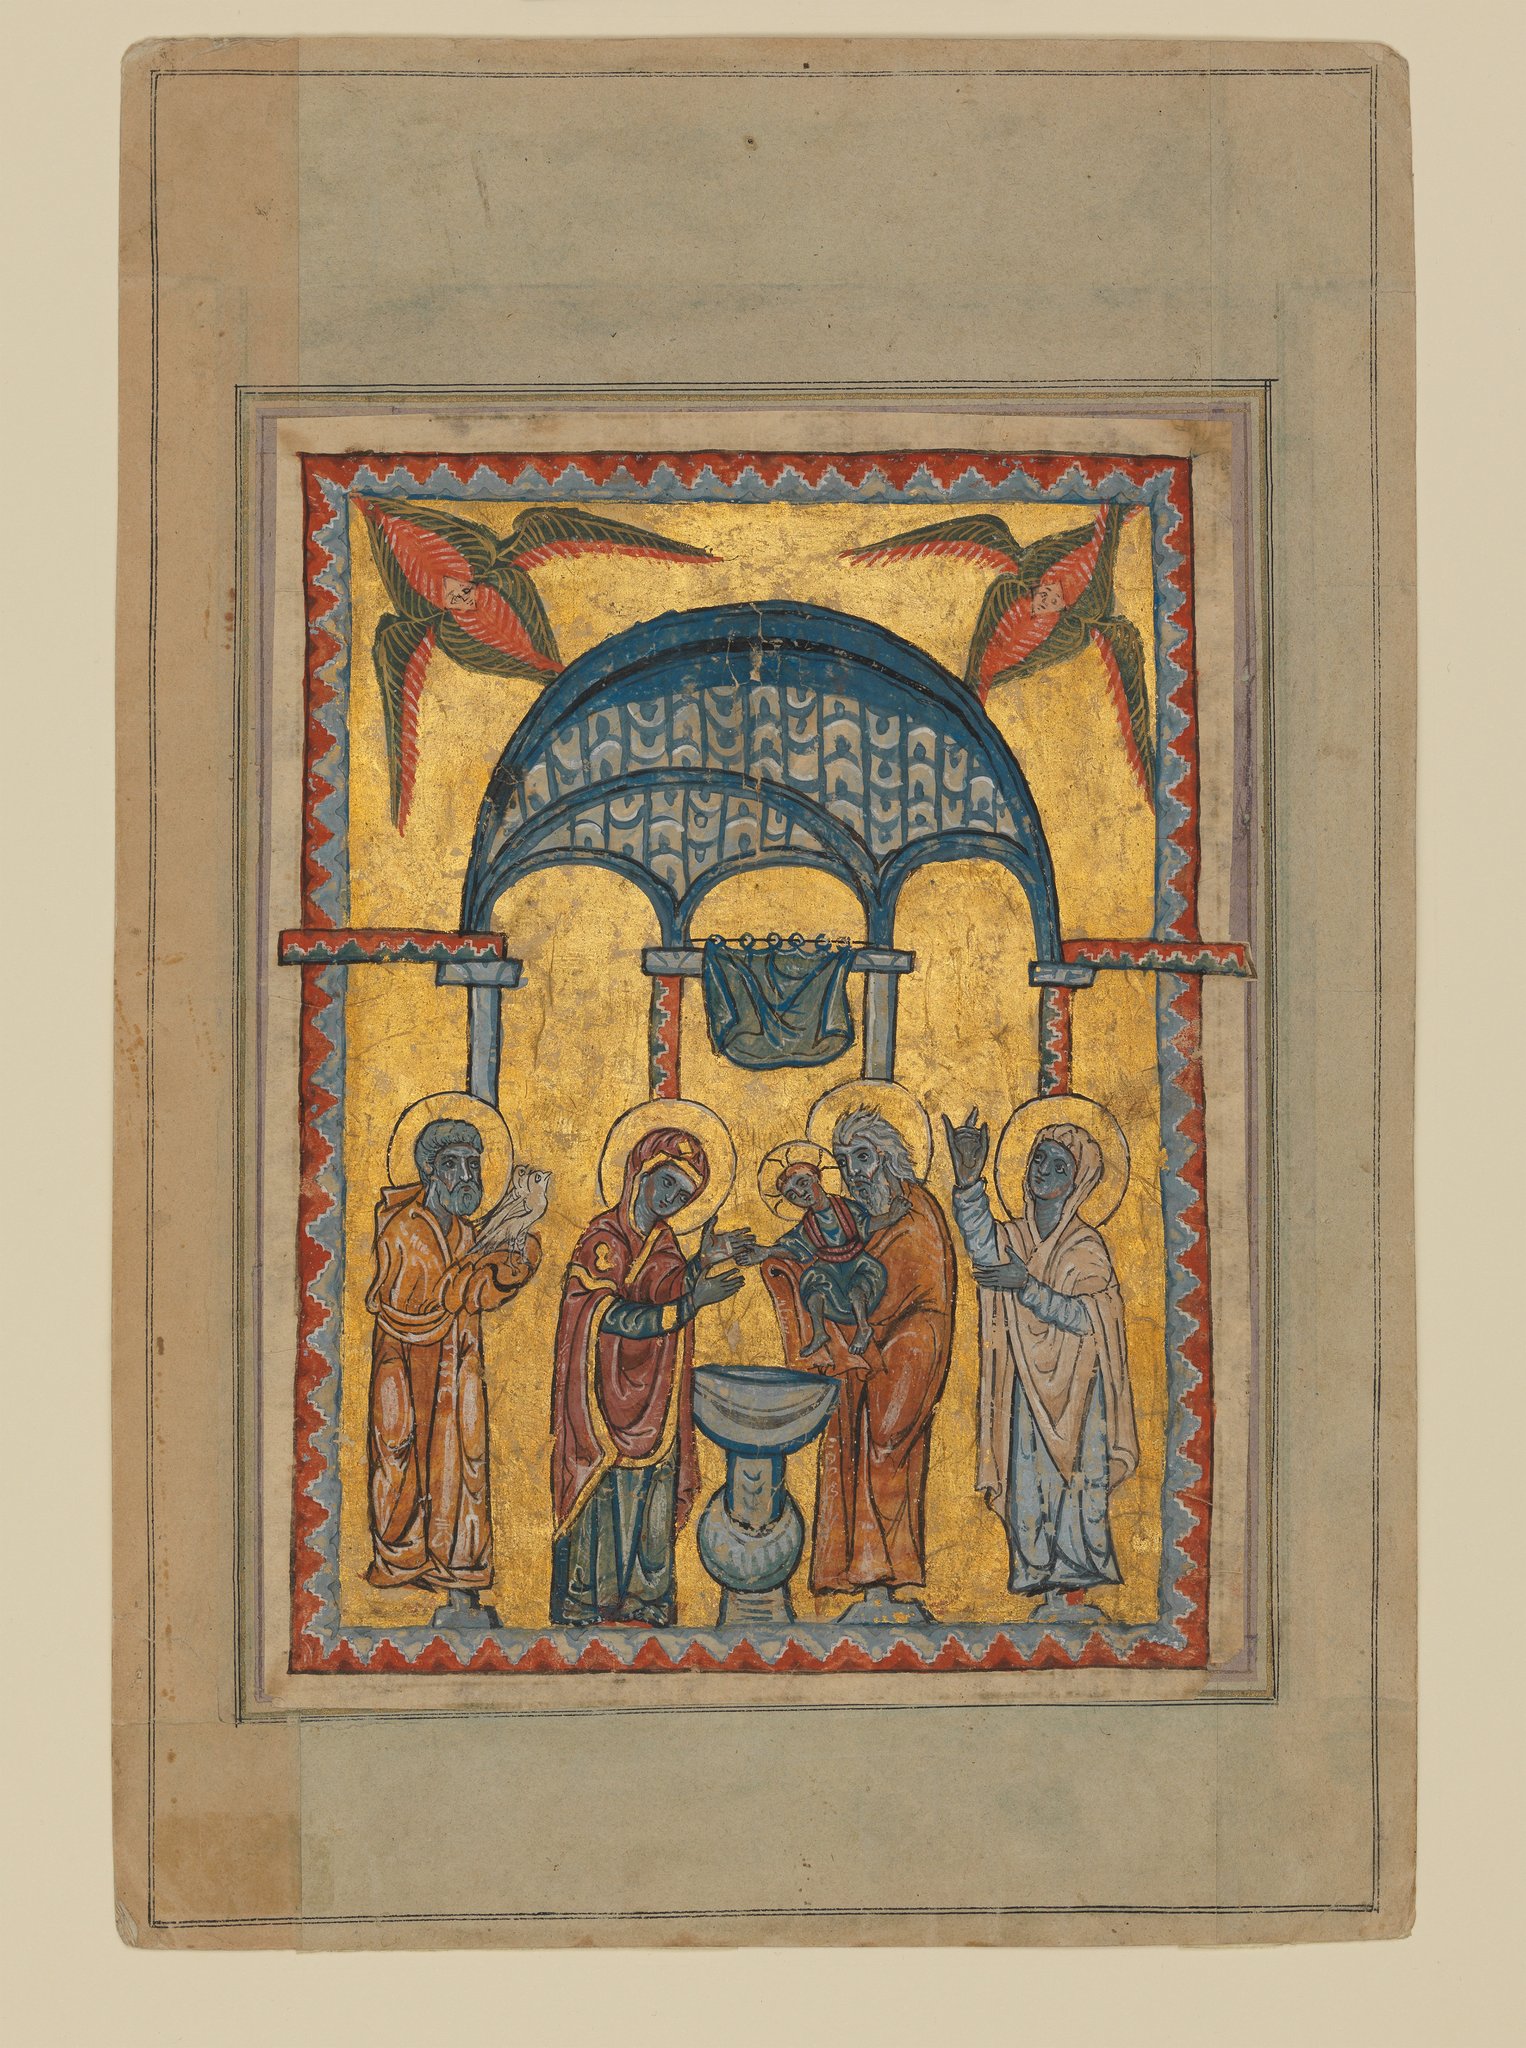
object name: four leaf from a gospel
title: Four miniatures of the life of Christ from a gospel book of 1311 (Presentation, Baptism, Transfiguration, Entry into Jerusalem)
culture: armenian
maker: t'oros the deacon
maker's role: artist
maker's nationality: armenian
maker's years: 1275-1325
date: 1311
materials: ink, paper, pigment